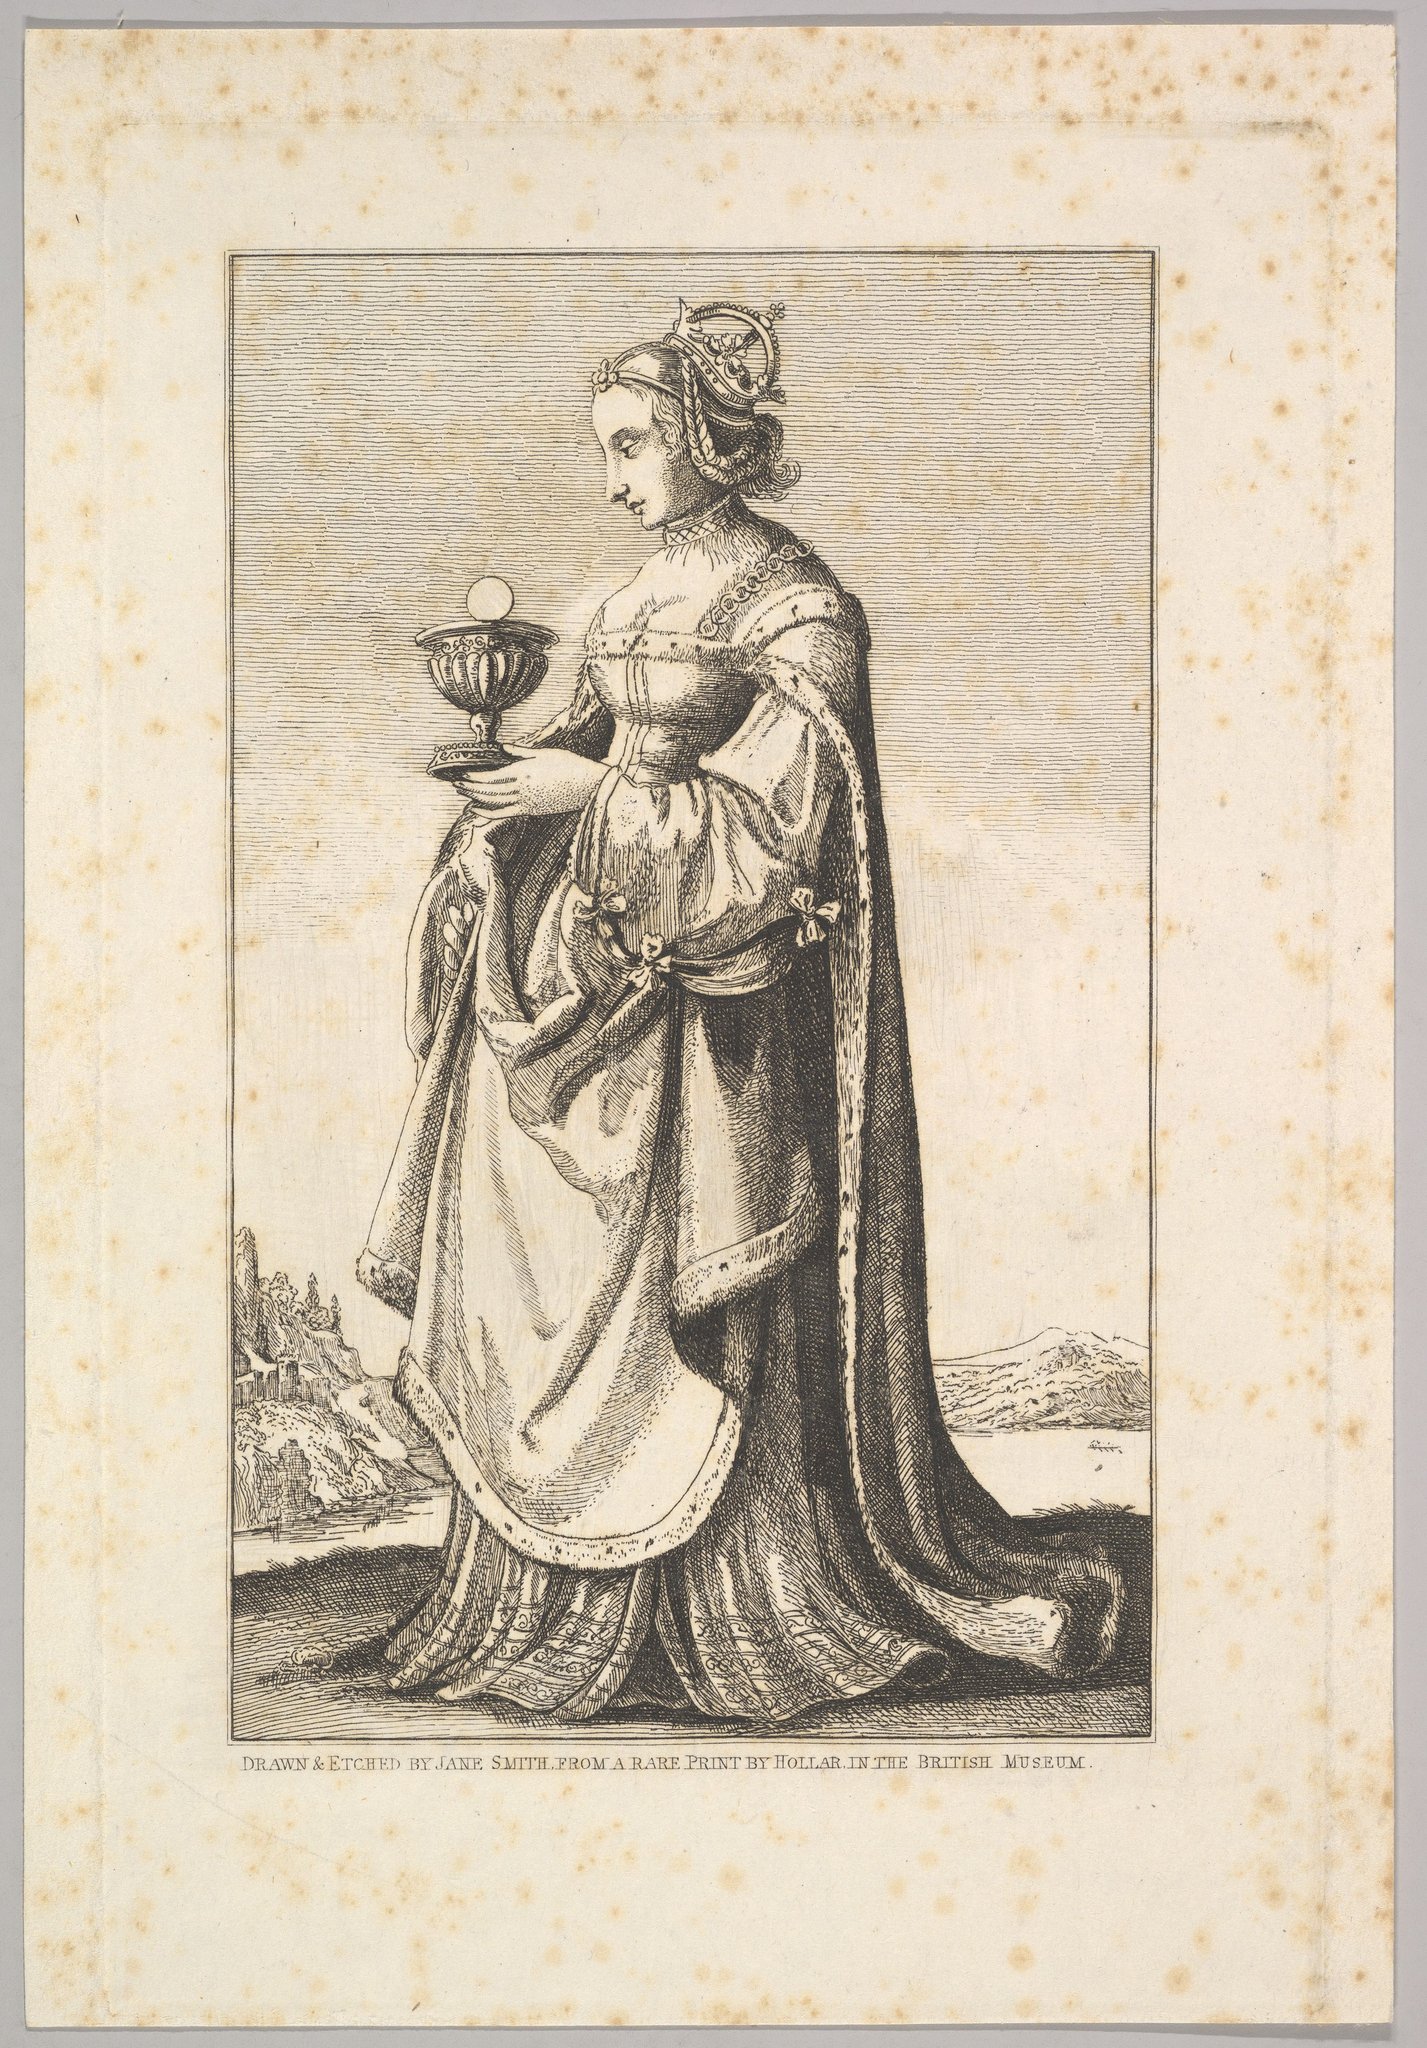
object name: print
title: Woman holding a chalice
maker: wenceslaus hollar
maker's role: artist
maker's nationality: bohemian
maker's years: 1607-1677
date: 1734-1900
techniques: etching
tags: profiles,women